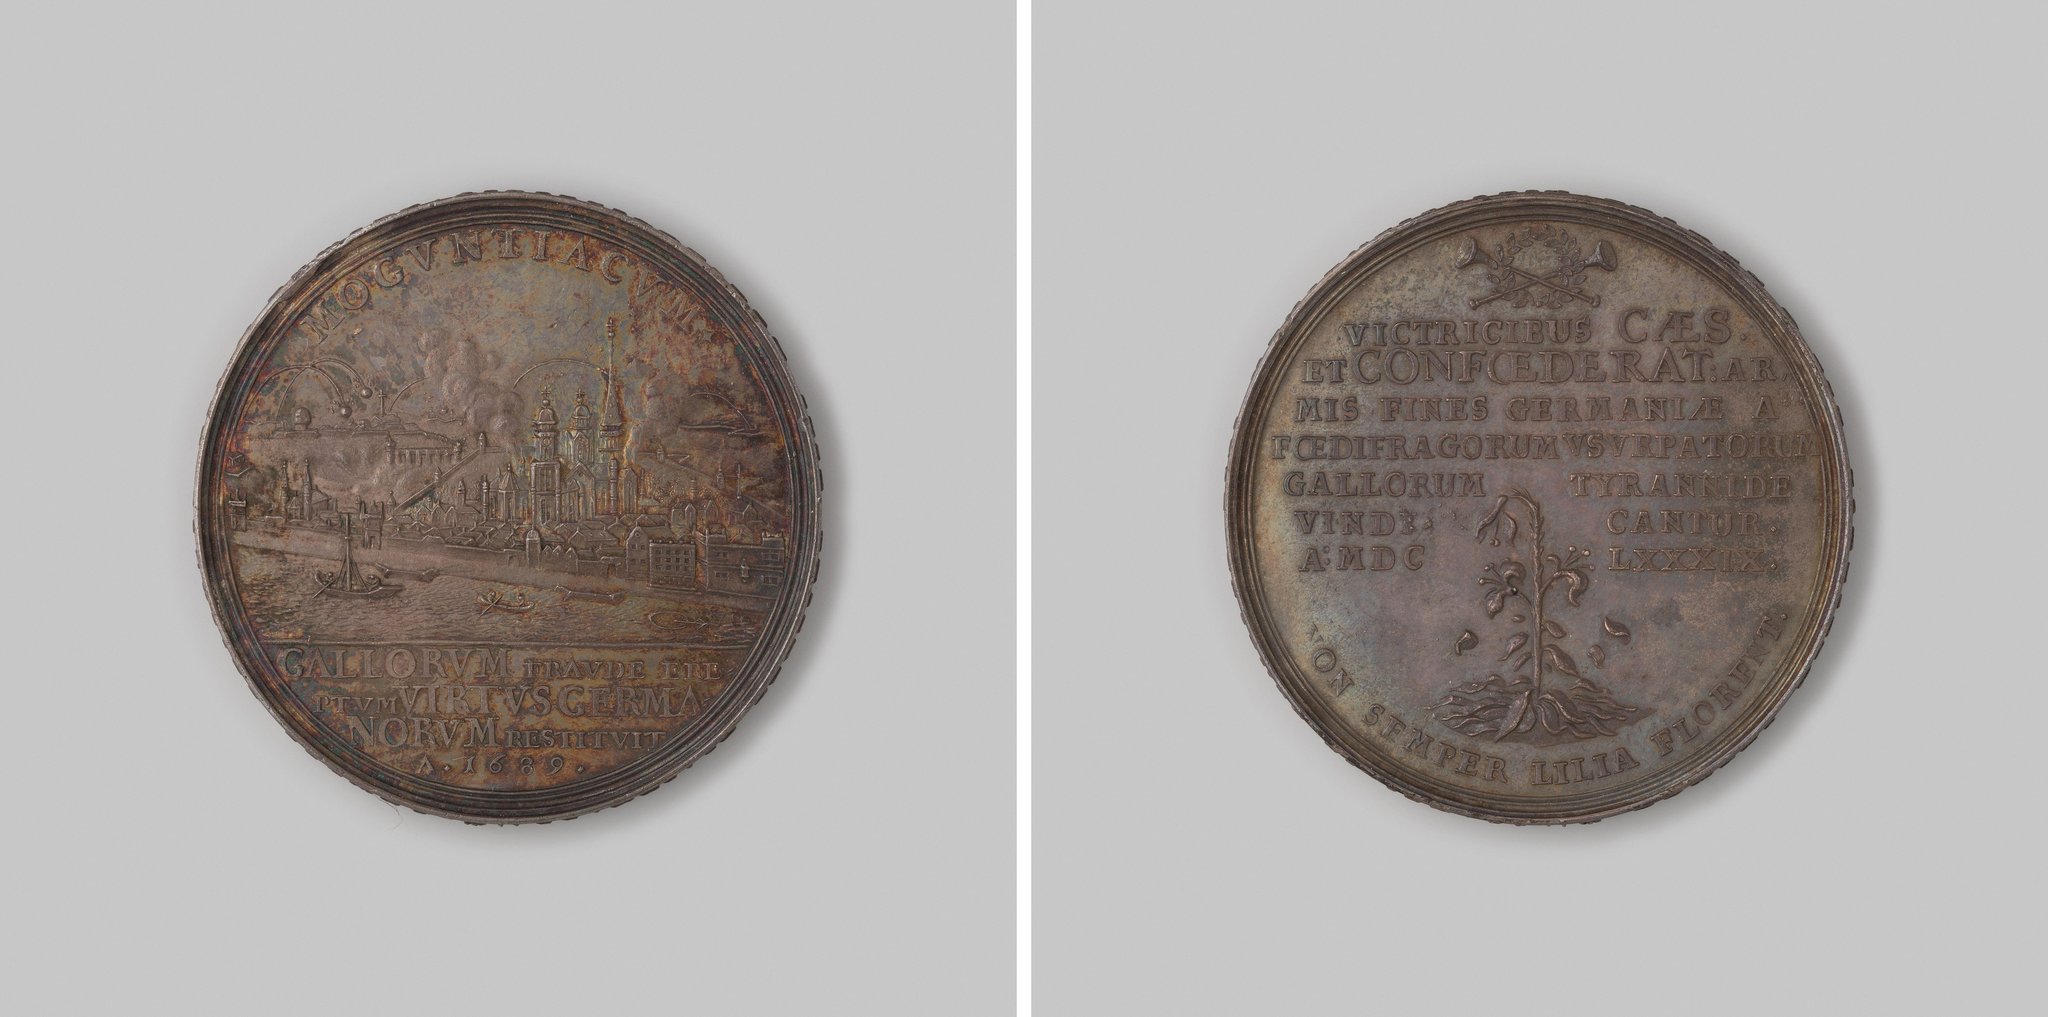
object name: history medal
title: Inname van Mainz door de keizerlijken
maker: Anonymous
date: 1689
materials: silver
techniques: striking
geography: germany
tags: mainz, rijnland-palts, inname van mainz, negenjarige oorlog